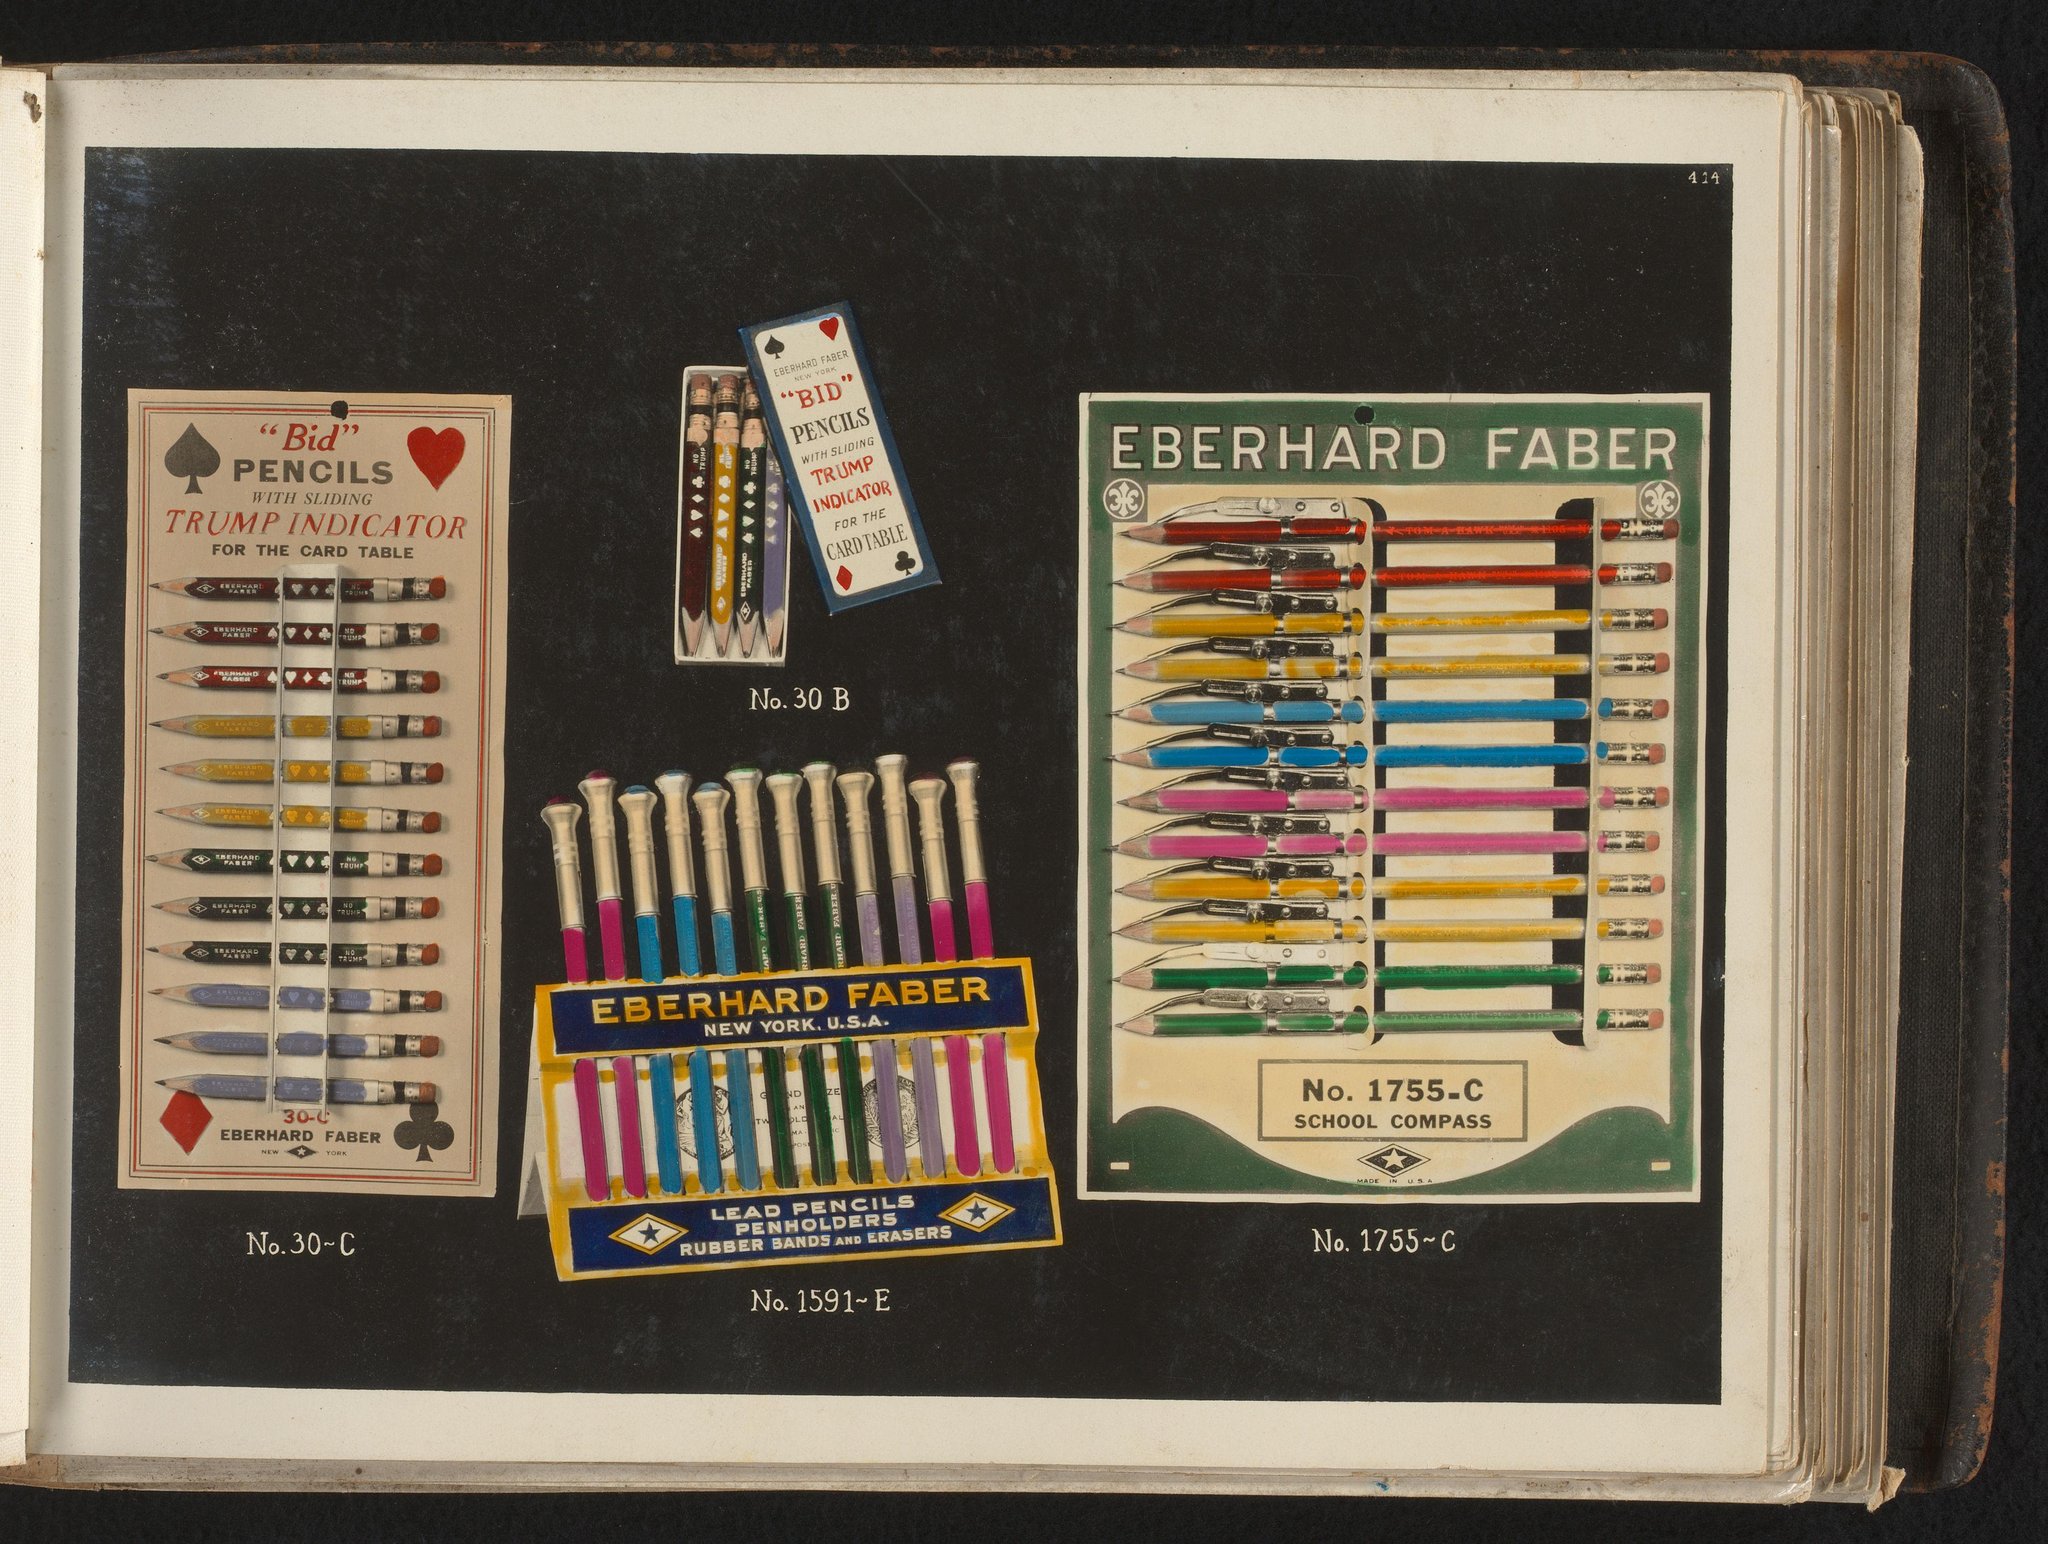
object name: photograph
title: Sets met potloden van Eberhard Faber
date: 1915-1935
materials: paper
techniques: gelatin silver print, hand coloring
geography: springfield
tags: pencil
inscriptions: stamp: ‘Paramount/ Commercial Studios/ 145 Chestnut St./ Springfield - Mass.’, number: ‘414’